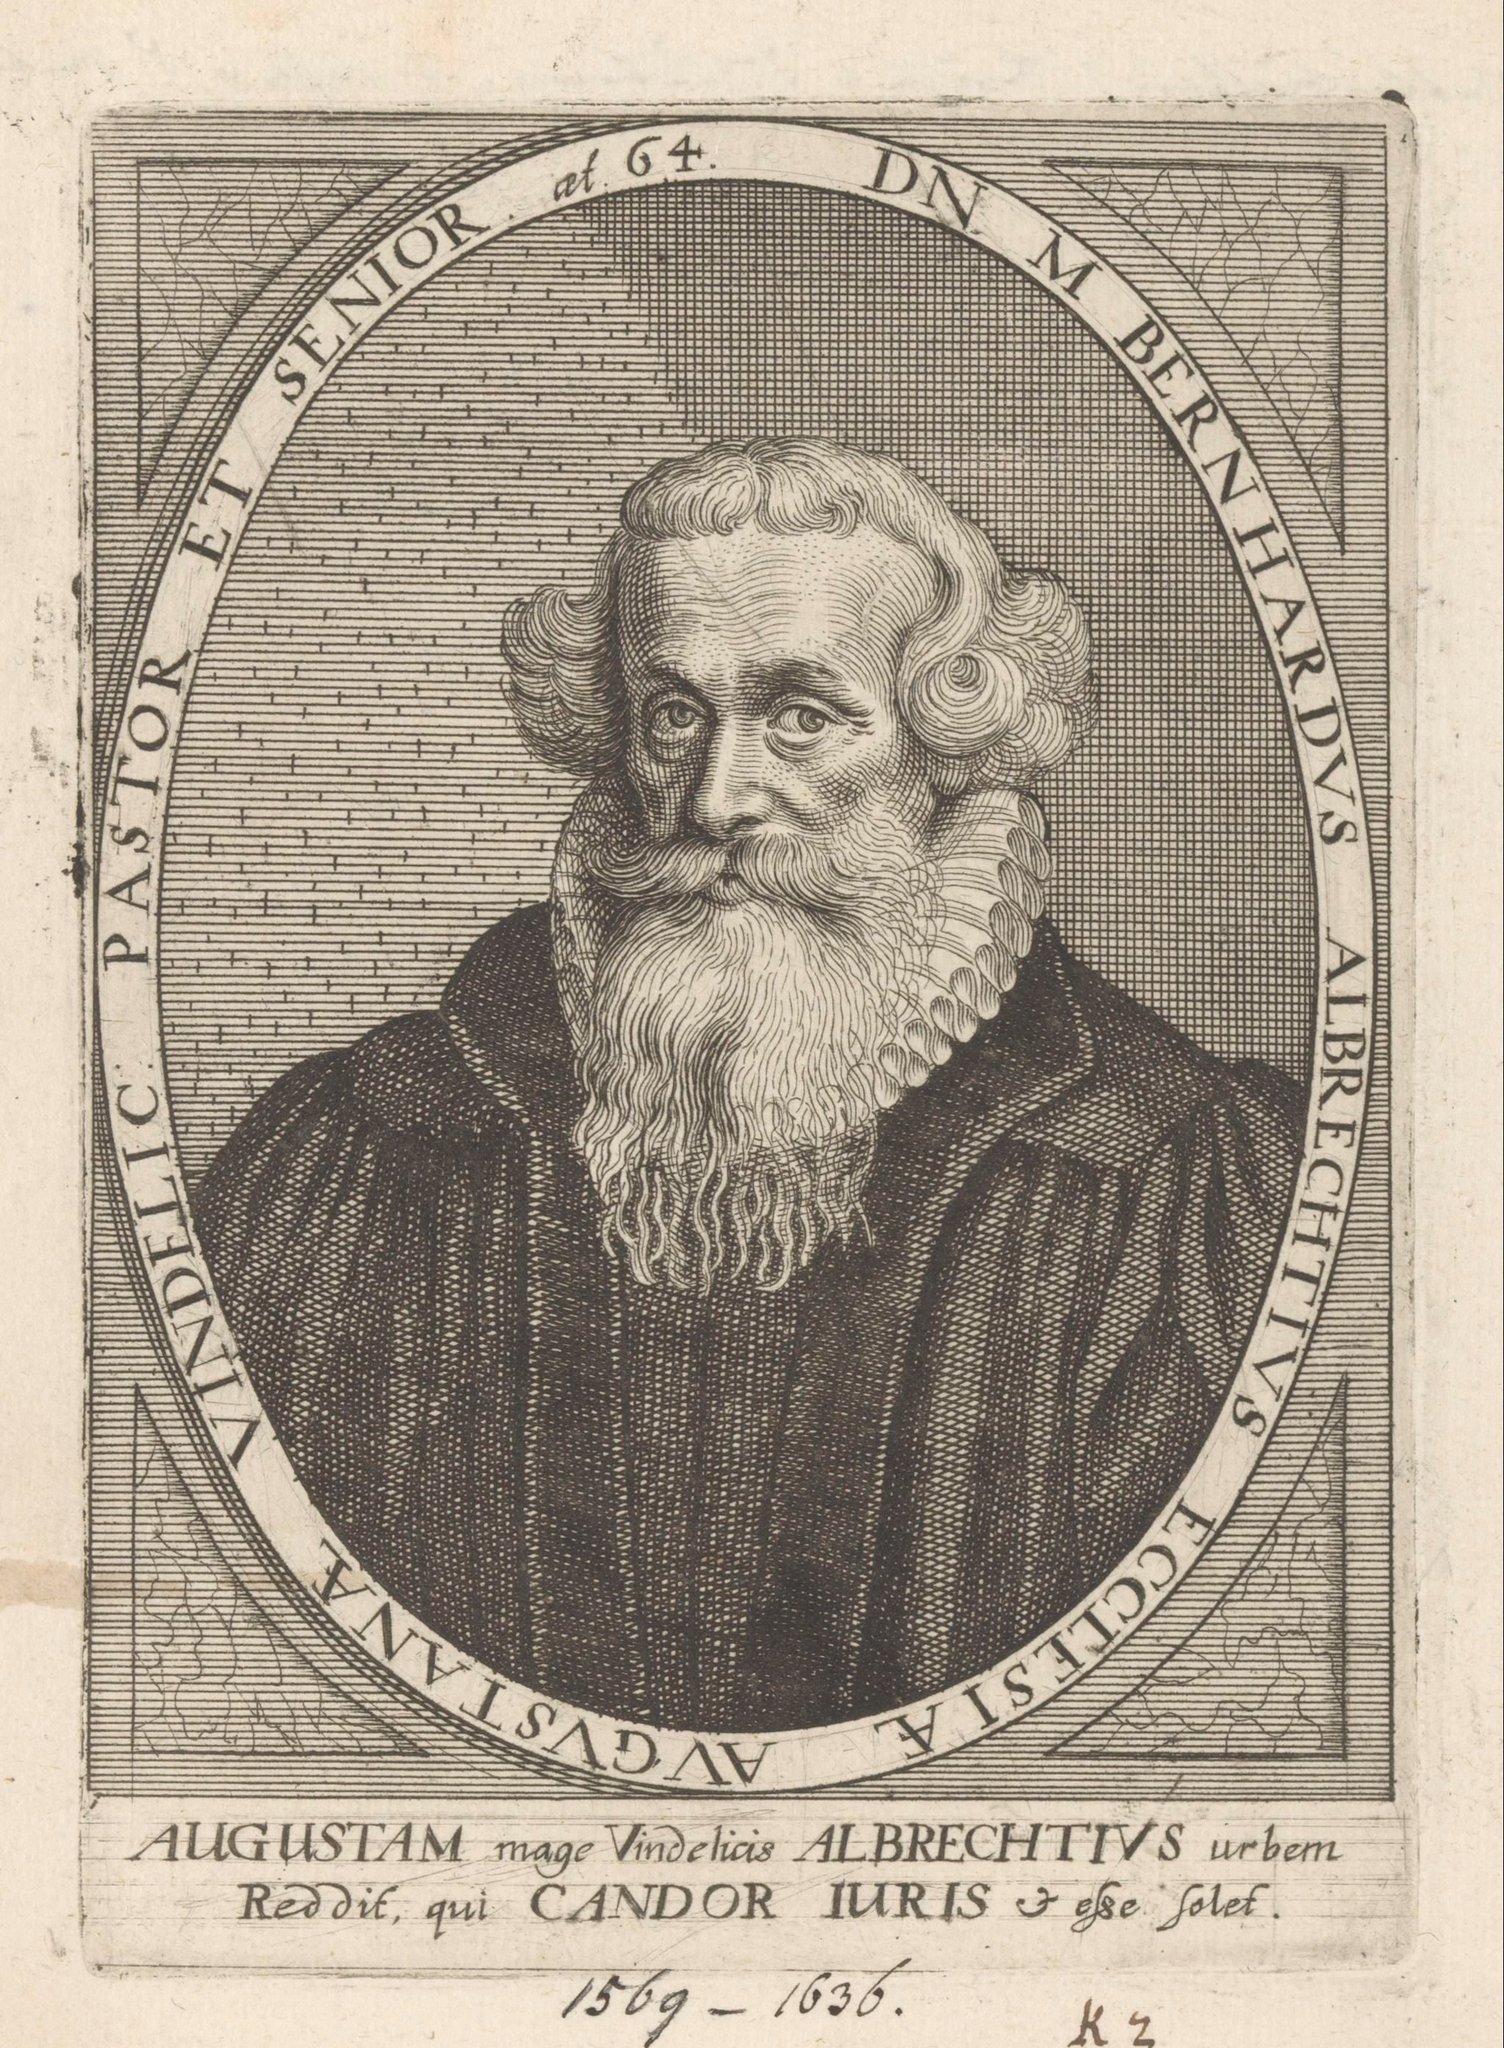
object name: print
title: Portret van Bernhard Albrecht op 64-jarige leeftijd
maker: Anonymous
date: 1633-1699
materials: paper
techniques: etching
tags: augsburg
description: Portret van Bernhard Albrecht in een ovale omlijsting met randschrift. In de ondermarge twee regels Latijnse tekst.